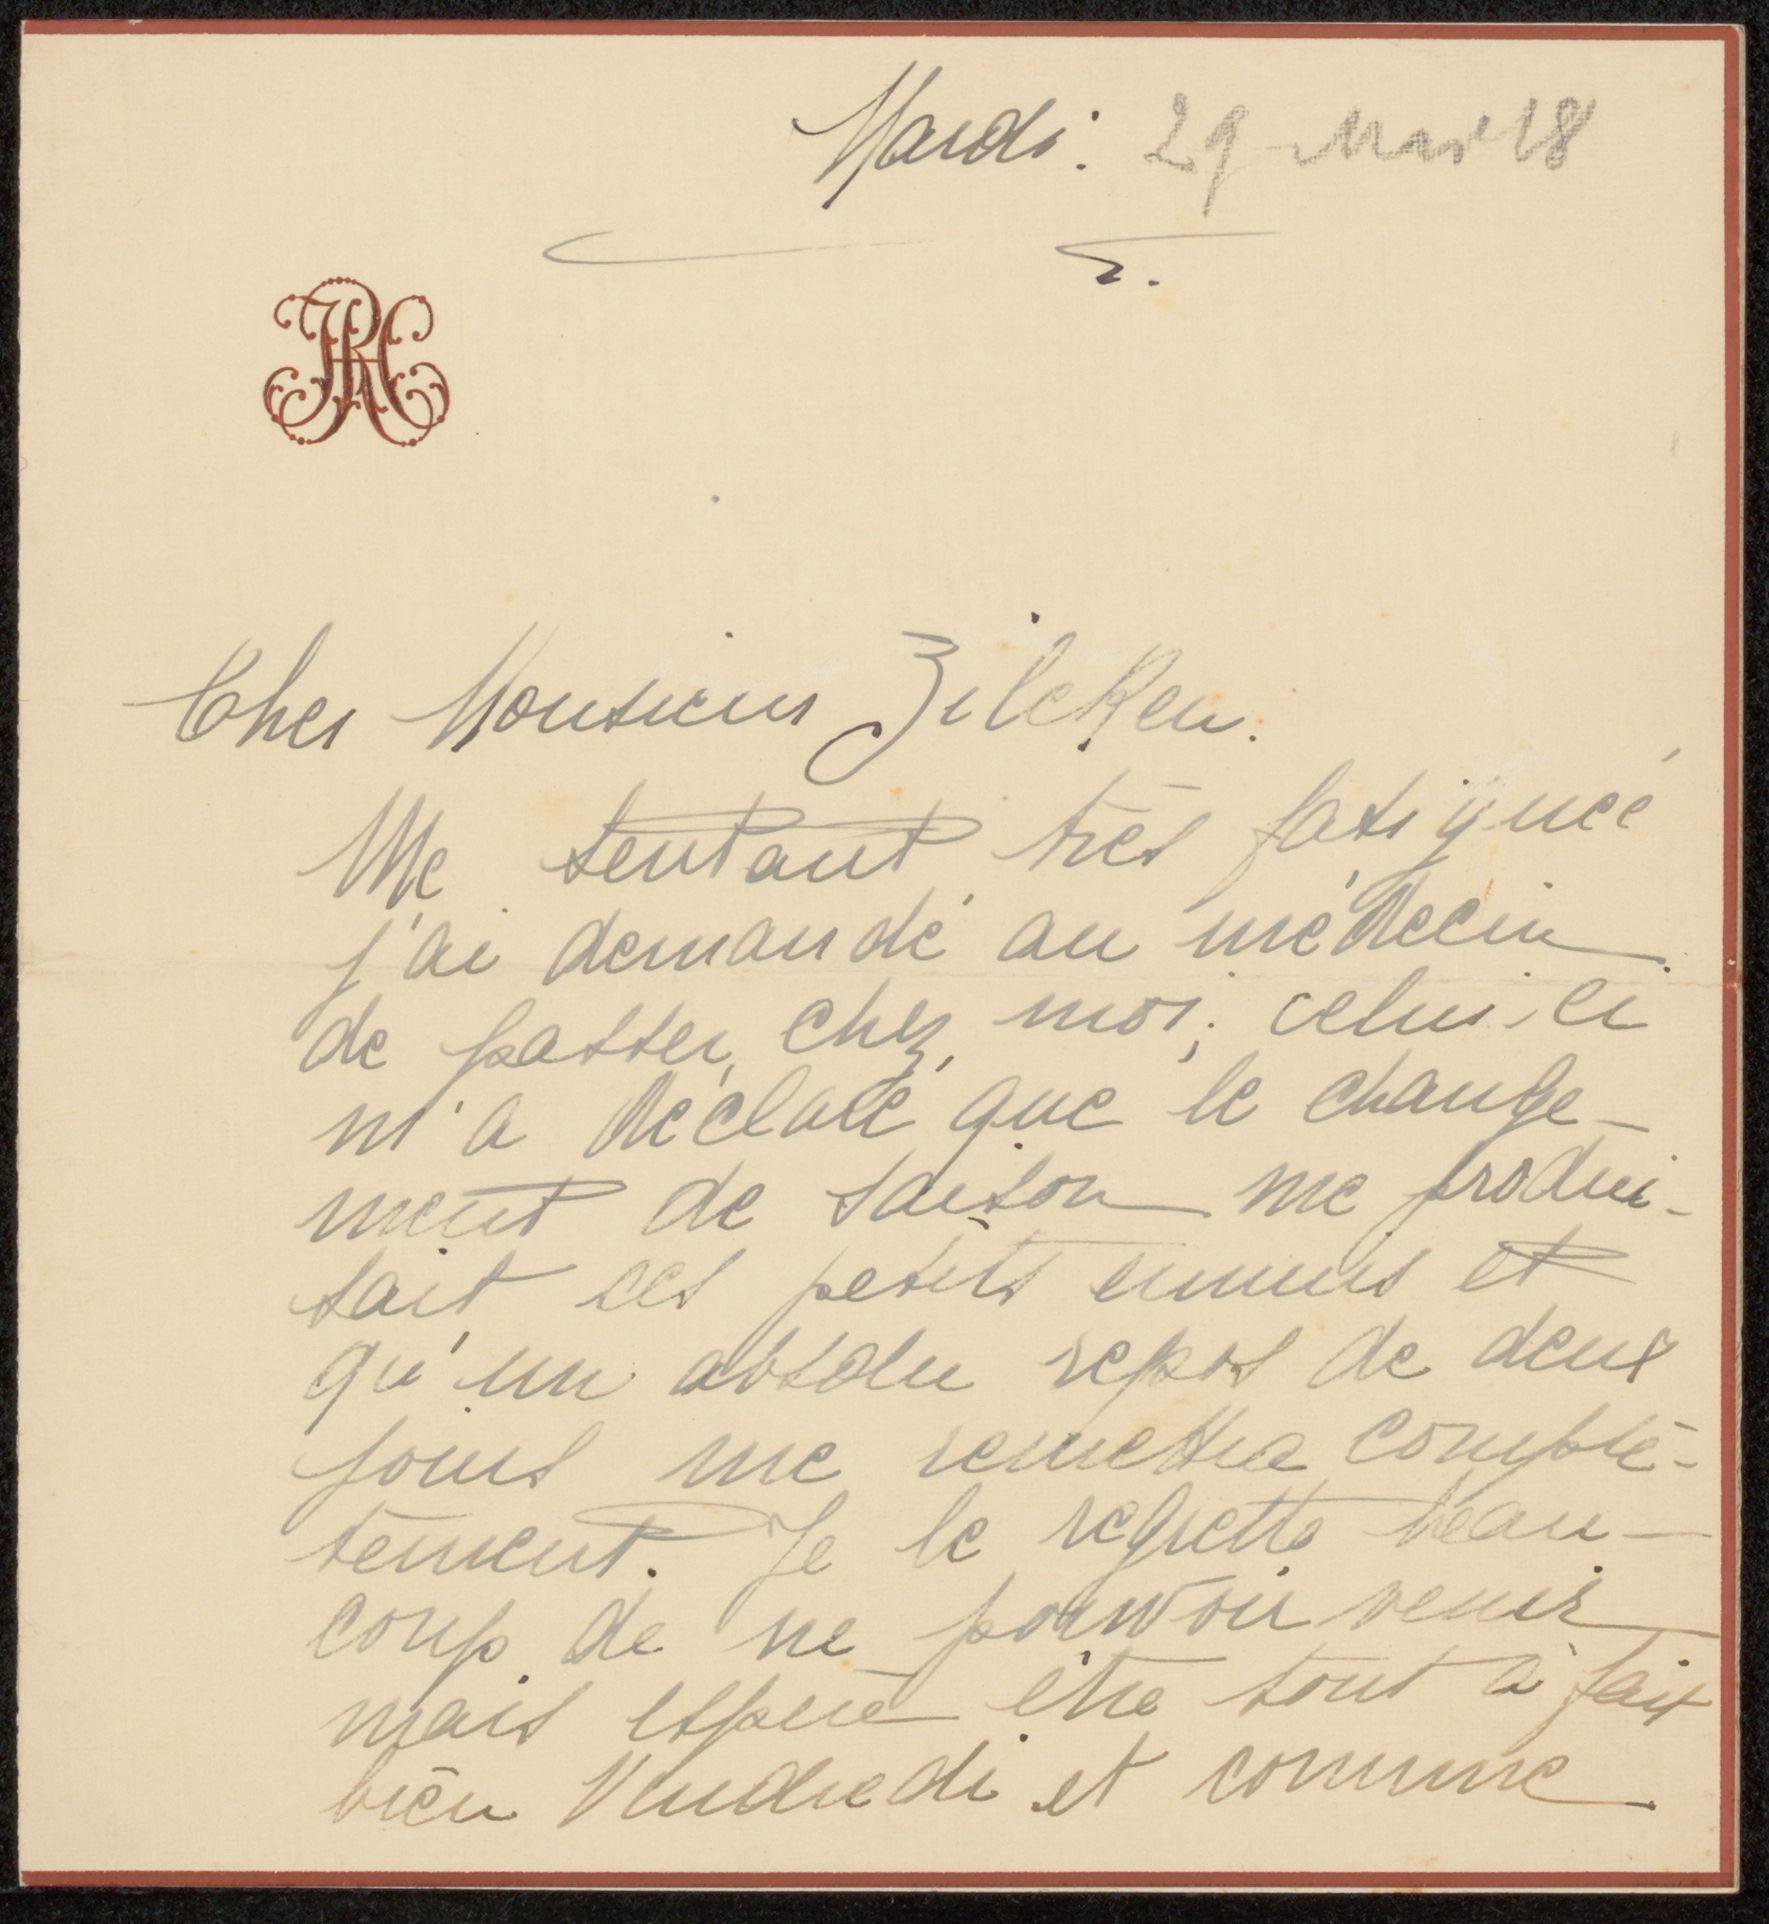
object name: letter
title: Brief aan Philip Zilcken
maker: rose imel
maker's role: draughtsman, painter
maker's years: 1901-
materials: ink, paper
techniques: pen, printing, writing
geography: scheveningen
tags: the hague, painter, draughtsman, philip zilcken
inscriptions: watermark, collector's mark: ‘RPK’, monogram: ‘RH’